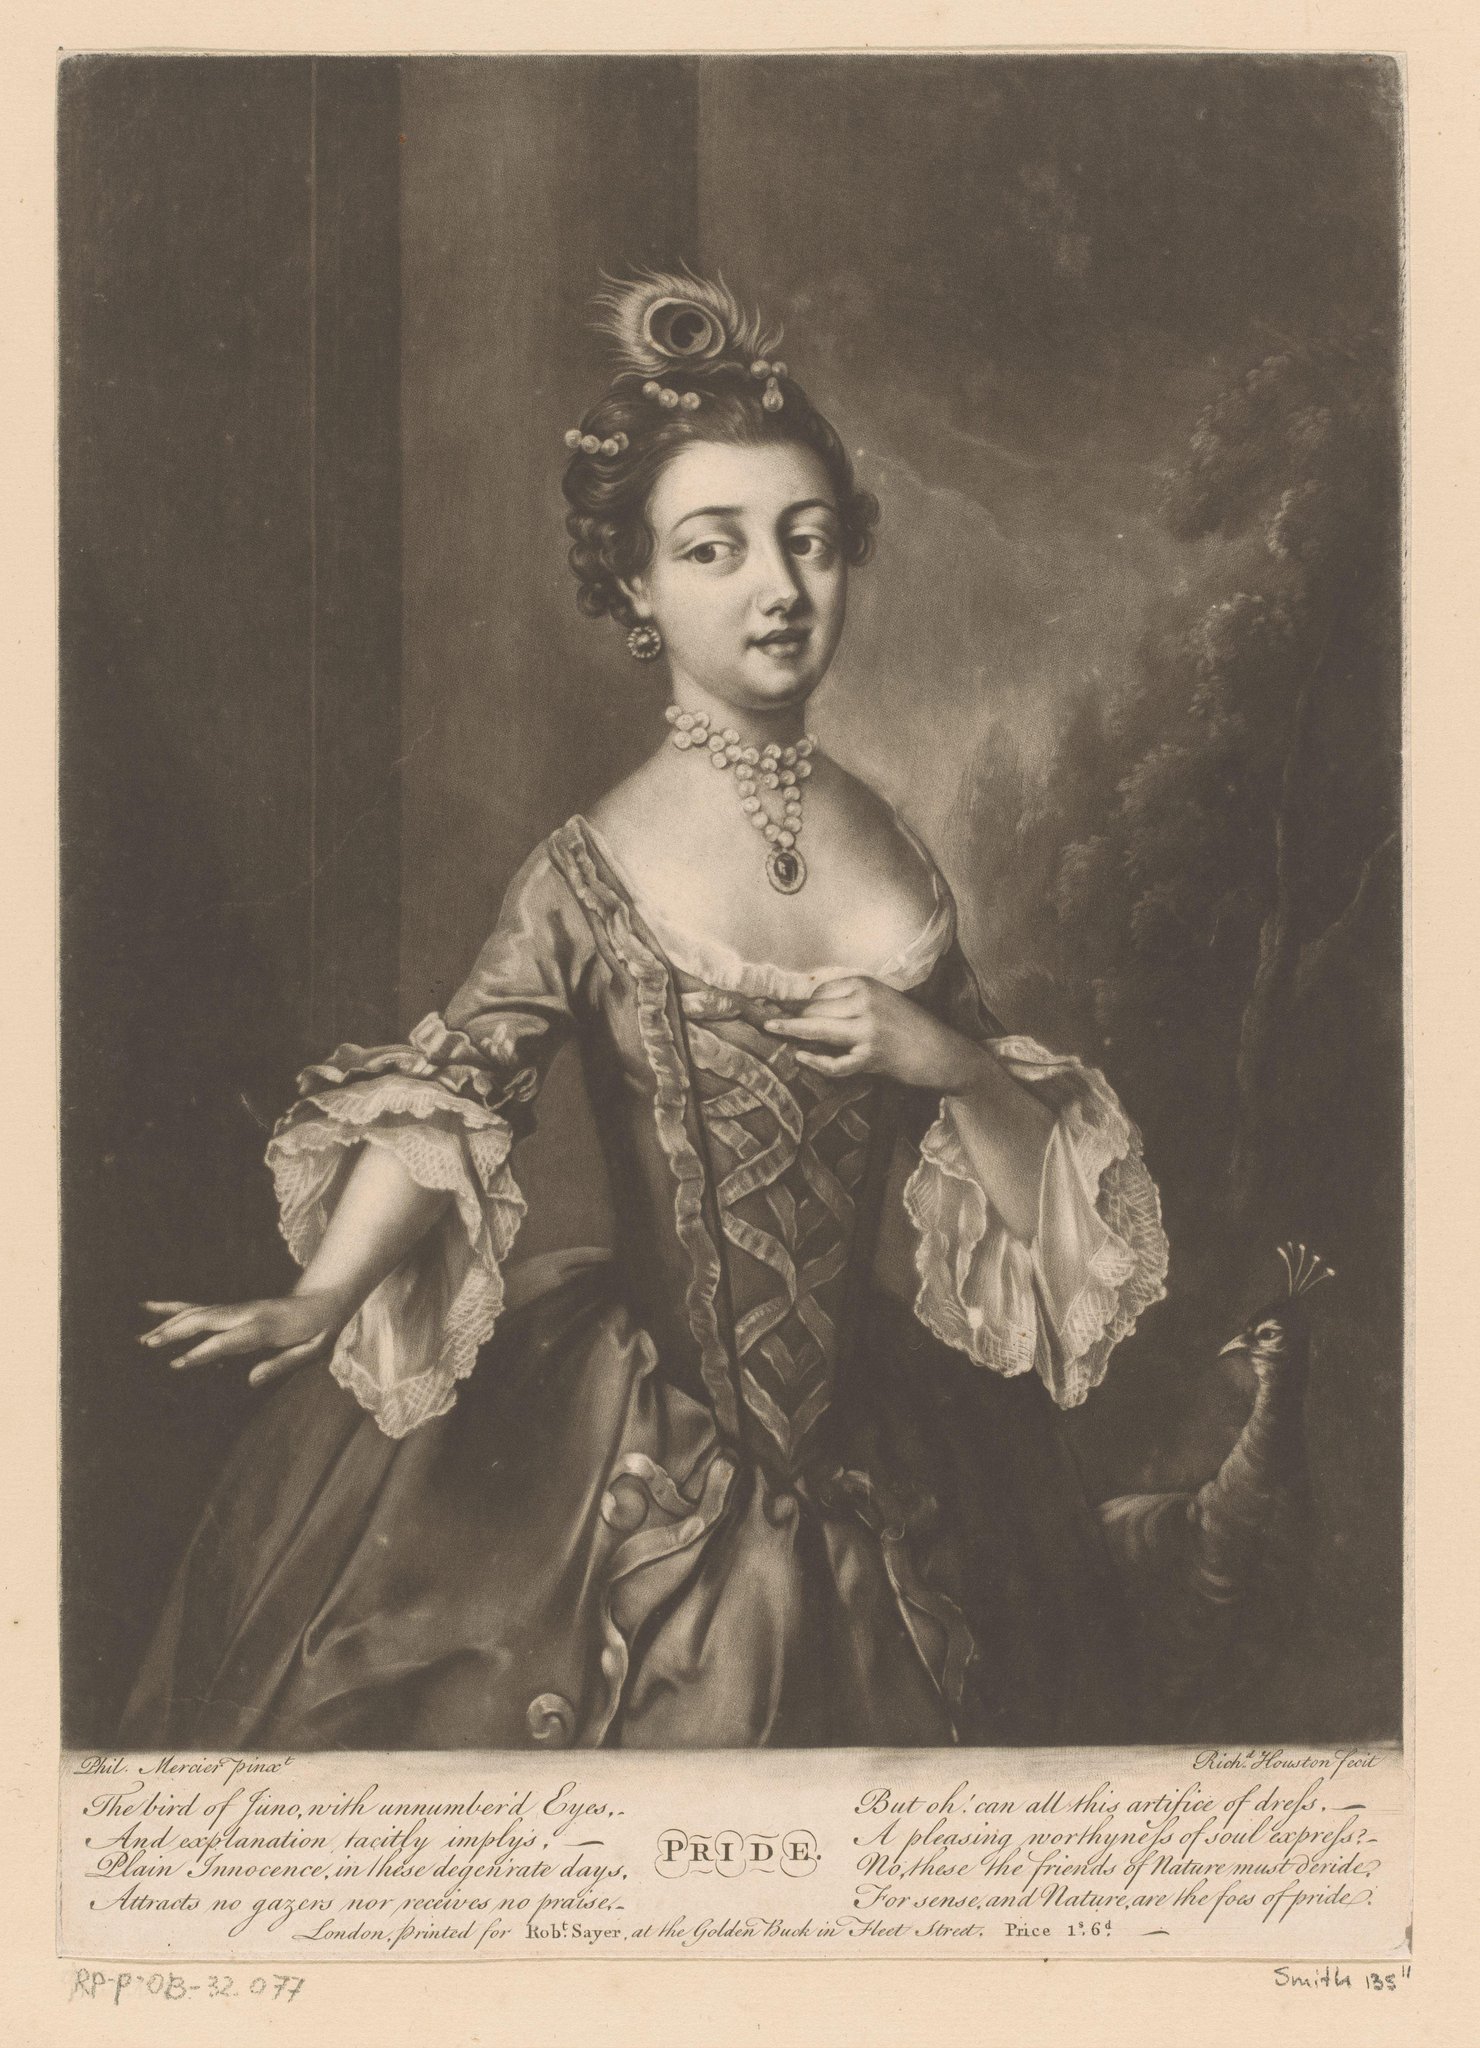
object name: print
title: Pride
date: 1731-1794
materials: paper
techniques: mezzotint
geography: london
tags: adolescent, young woman, maiden, pride; 'superbia' (ripa) ~ personification of one of the seven deadly sins, pearl; pearl necklace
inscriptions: collector's mark: Lugt 240